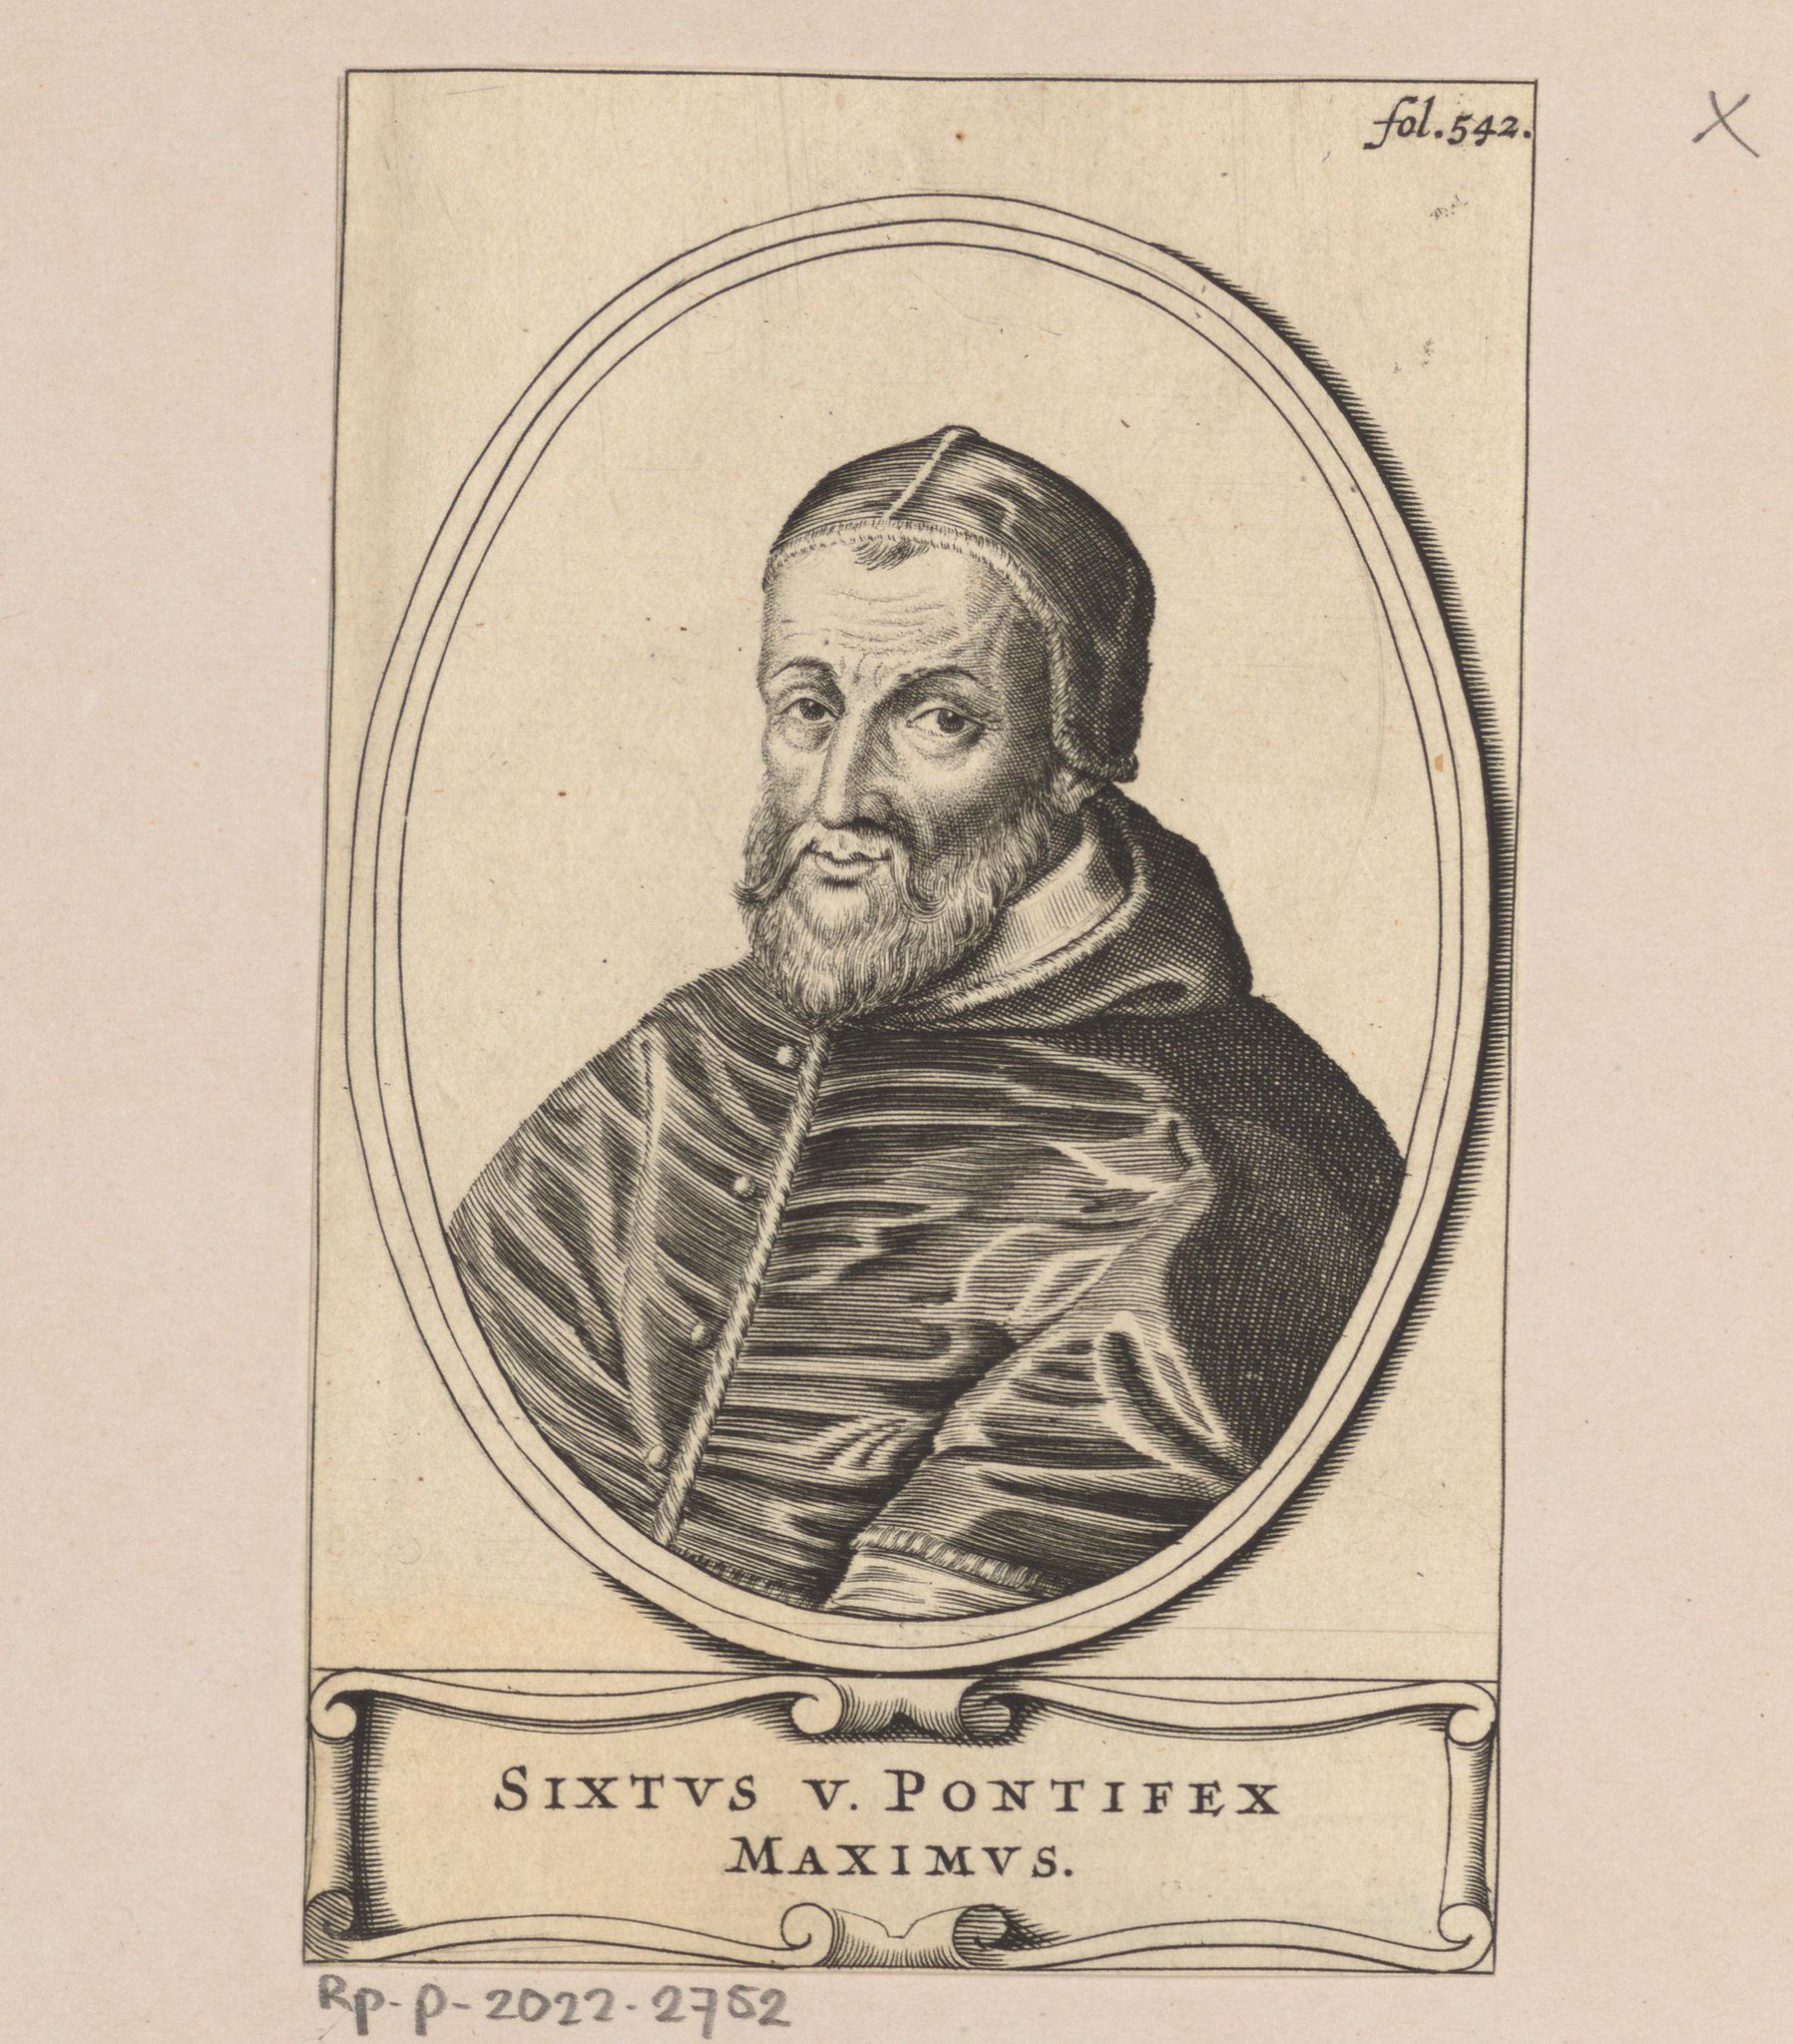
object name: print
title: Portret van Sixtus V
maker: Anonymous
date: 1650-1660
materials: paper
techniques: engraving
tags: rome, sixtus v, historical persons, pope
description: Prent mogelijk uit een editie van: Het treur-toonneel der doorluchtige mannen onser eeuwe. Waer op den val der grooten levendigh vertoont wordt. Amsterdam en Rotterdam: Nicolaes van Ravesteyn, Andries van Hoogenhuysen, Jan Jacobsz. Schipper en Abraham Wolfgang, 1650-1660.